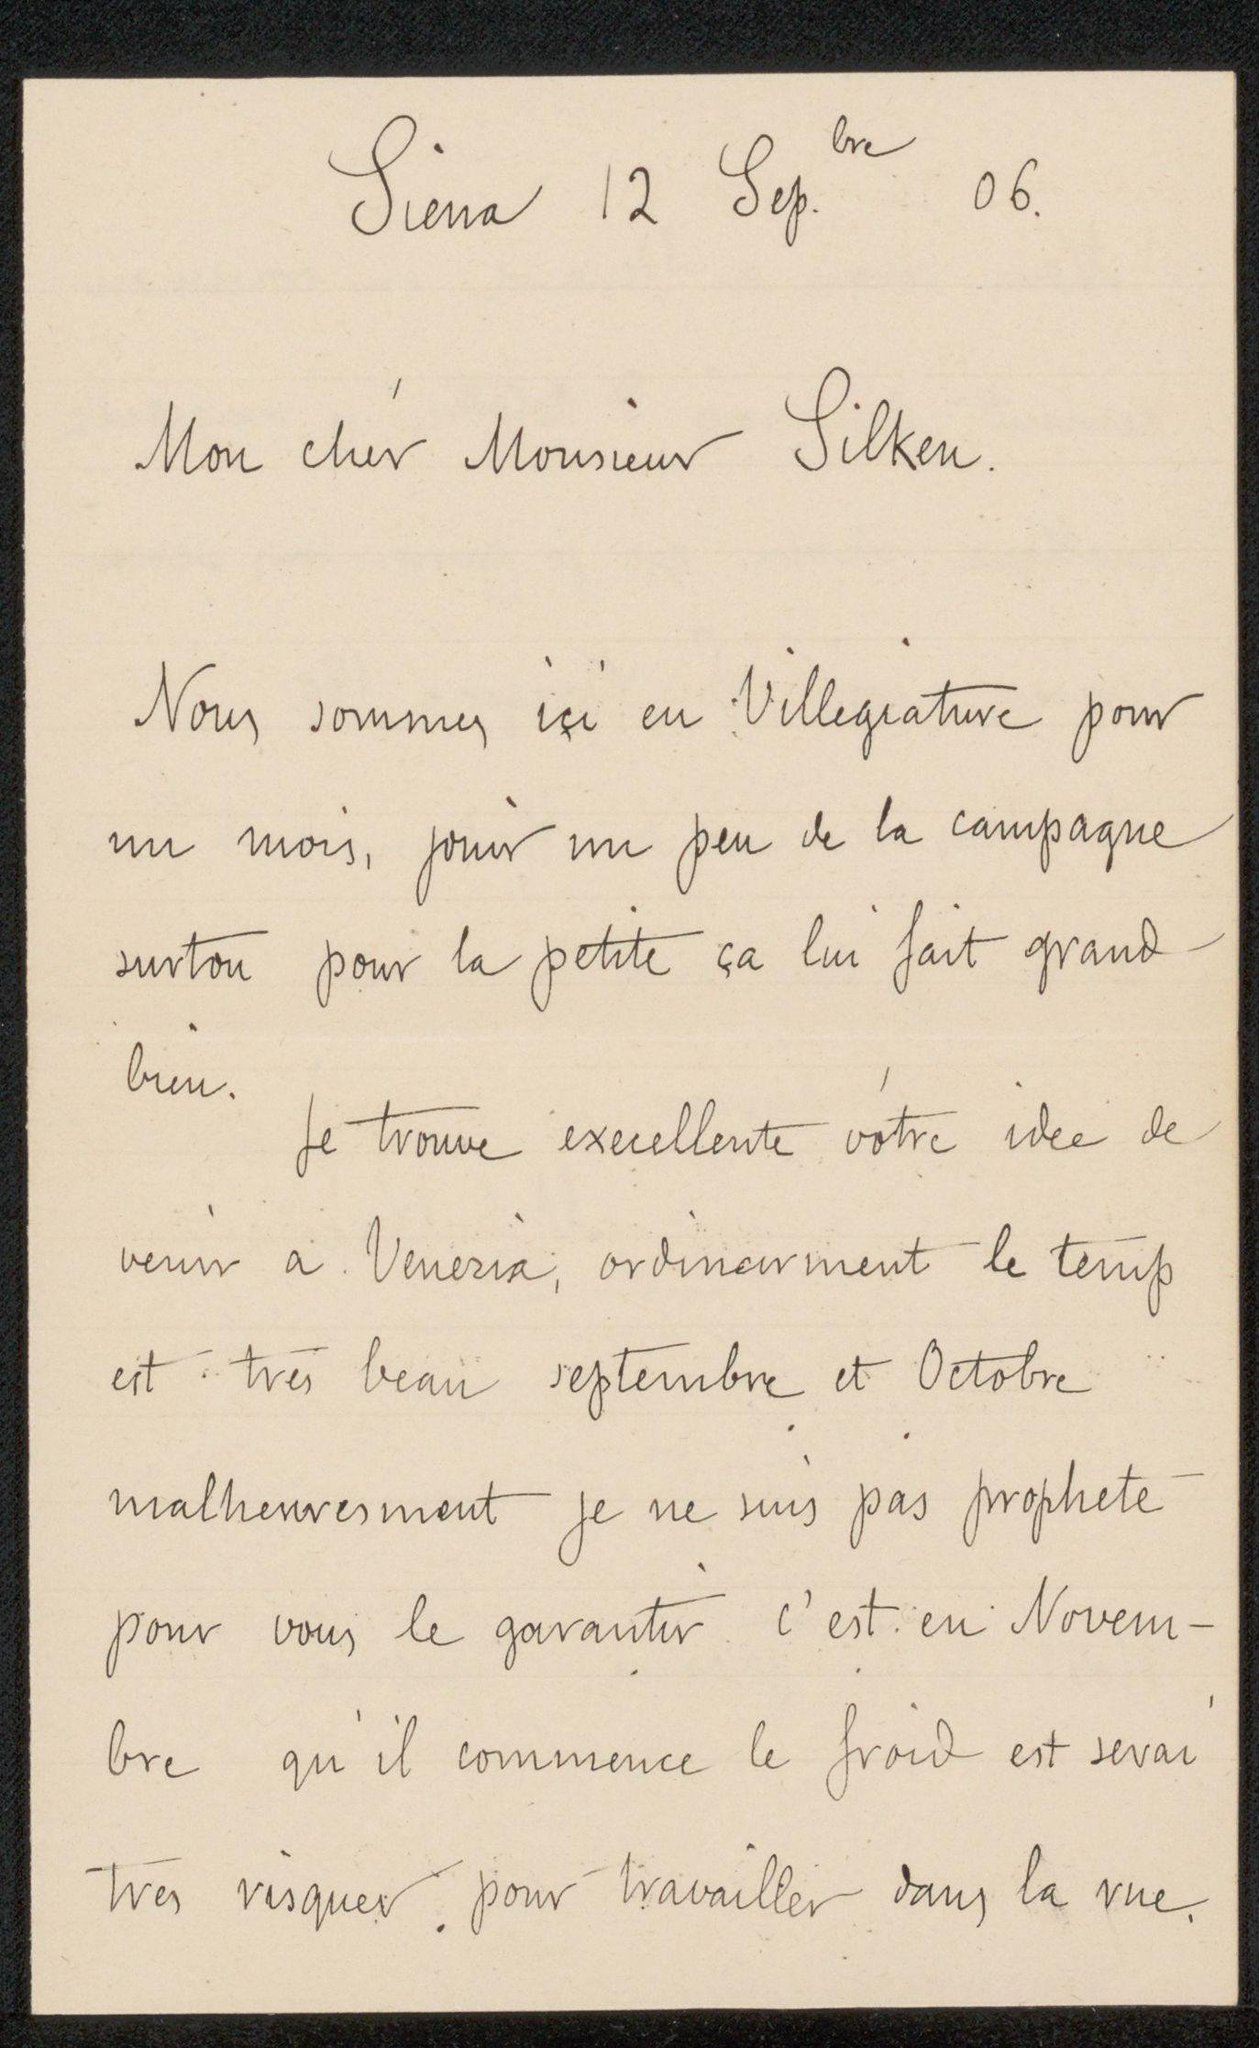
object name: letter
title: Brief aan Philip Zilcken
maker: martín rico ortega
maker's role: painter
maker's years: 1833-1908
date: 1906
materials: ink, paper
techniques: pen, writing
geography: siena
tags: draughtsman, philip zilcken, travelling; tourism, venice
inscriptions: collector's mark: ‘RPK’